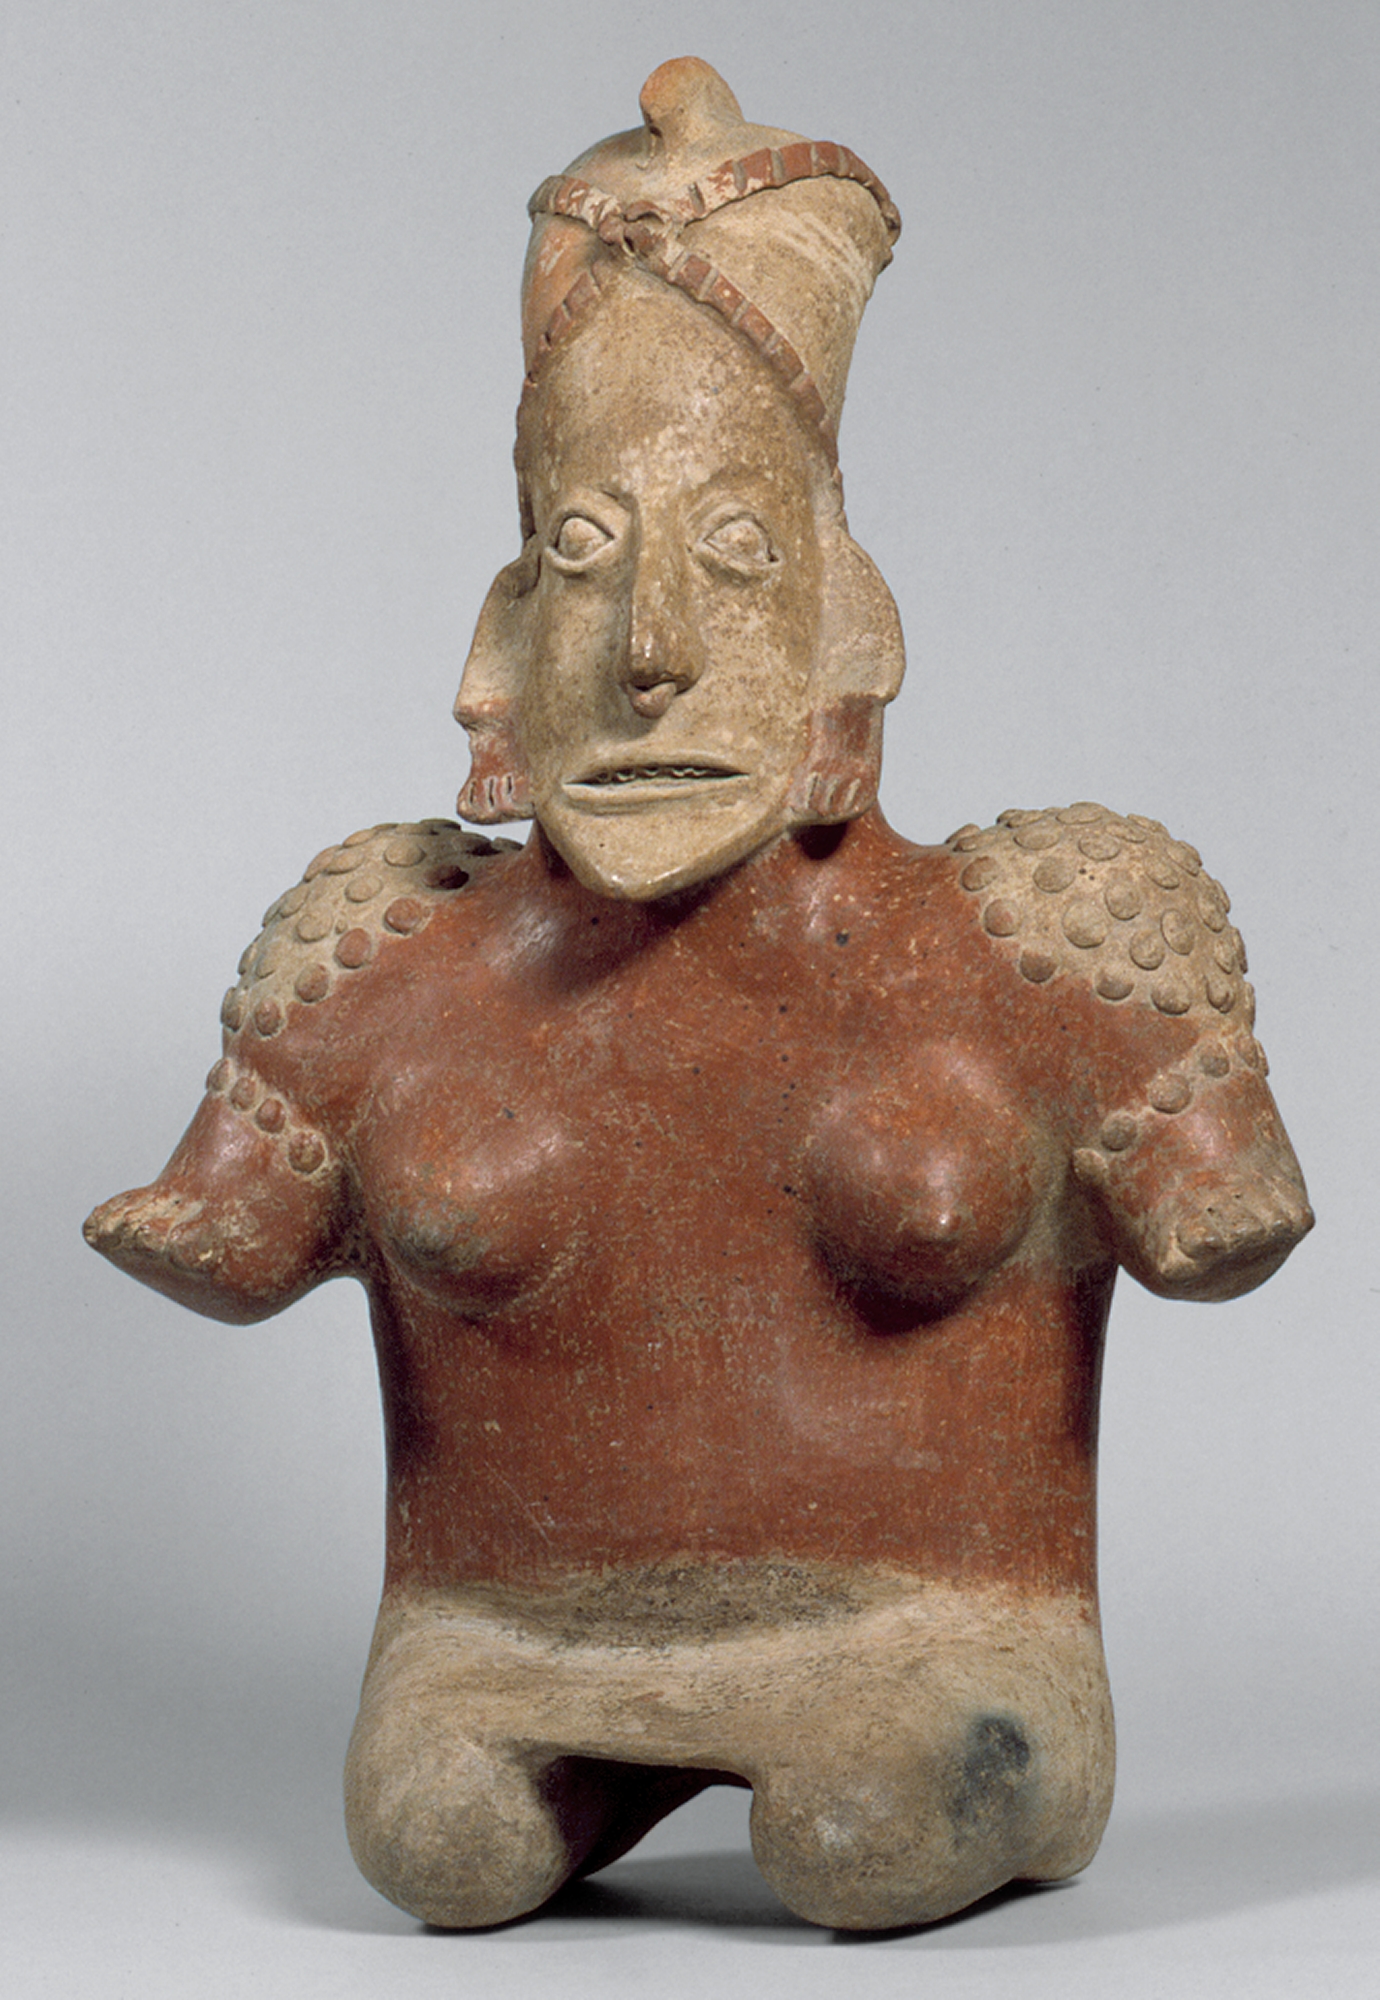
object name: female figure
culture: jalisco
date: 100 BCE-300 CE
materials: ceramic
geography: mexico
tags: female nudes